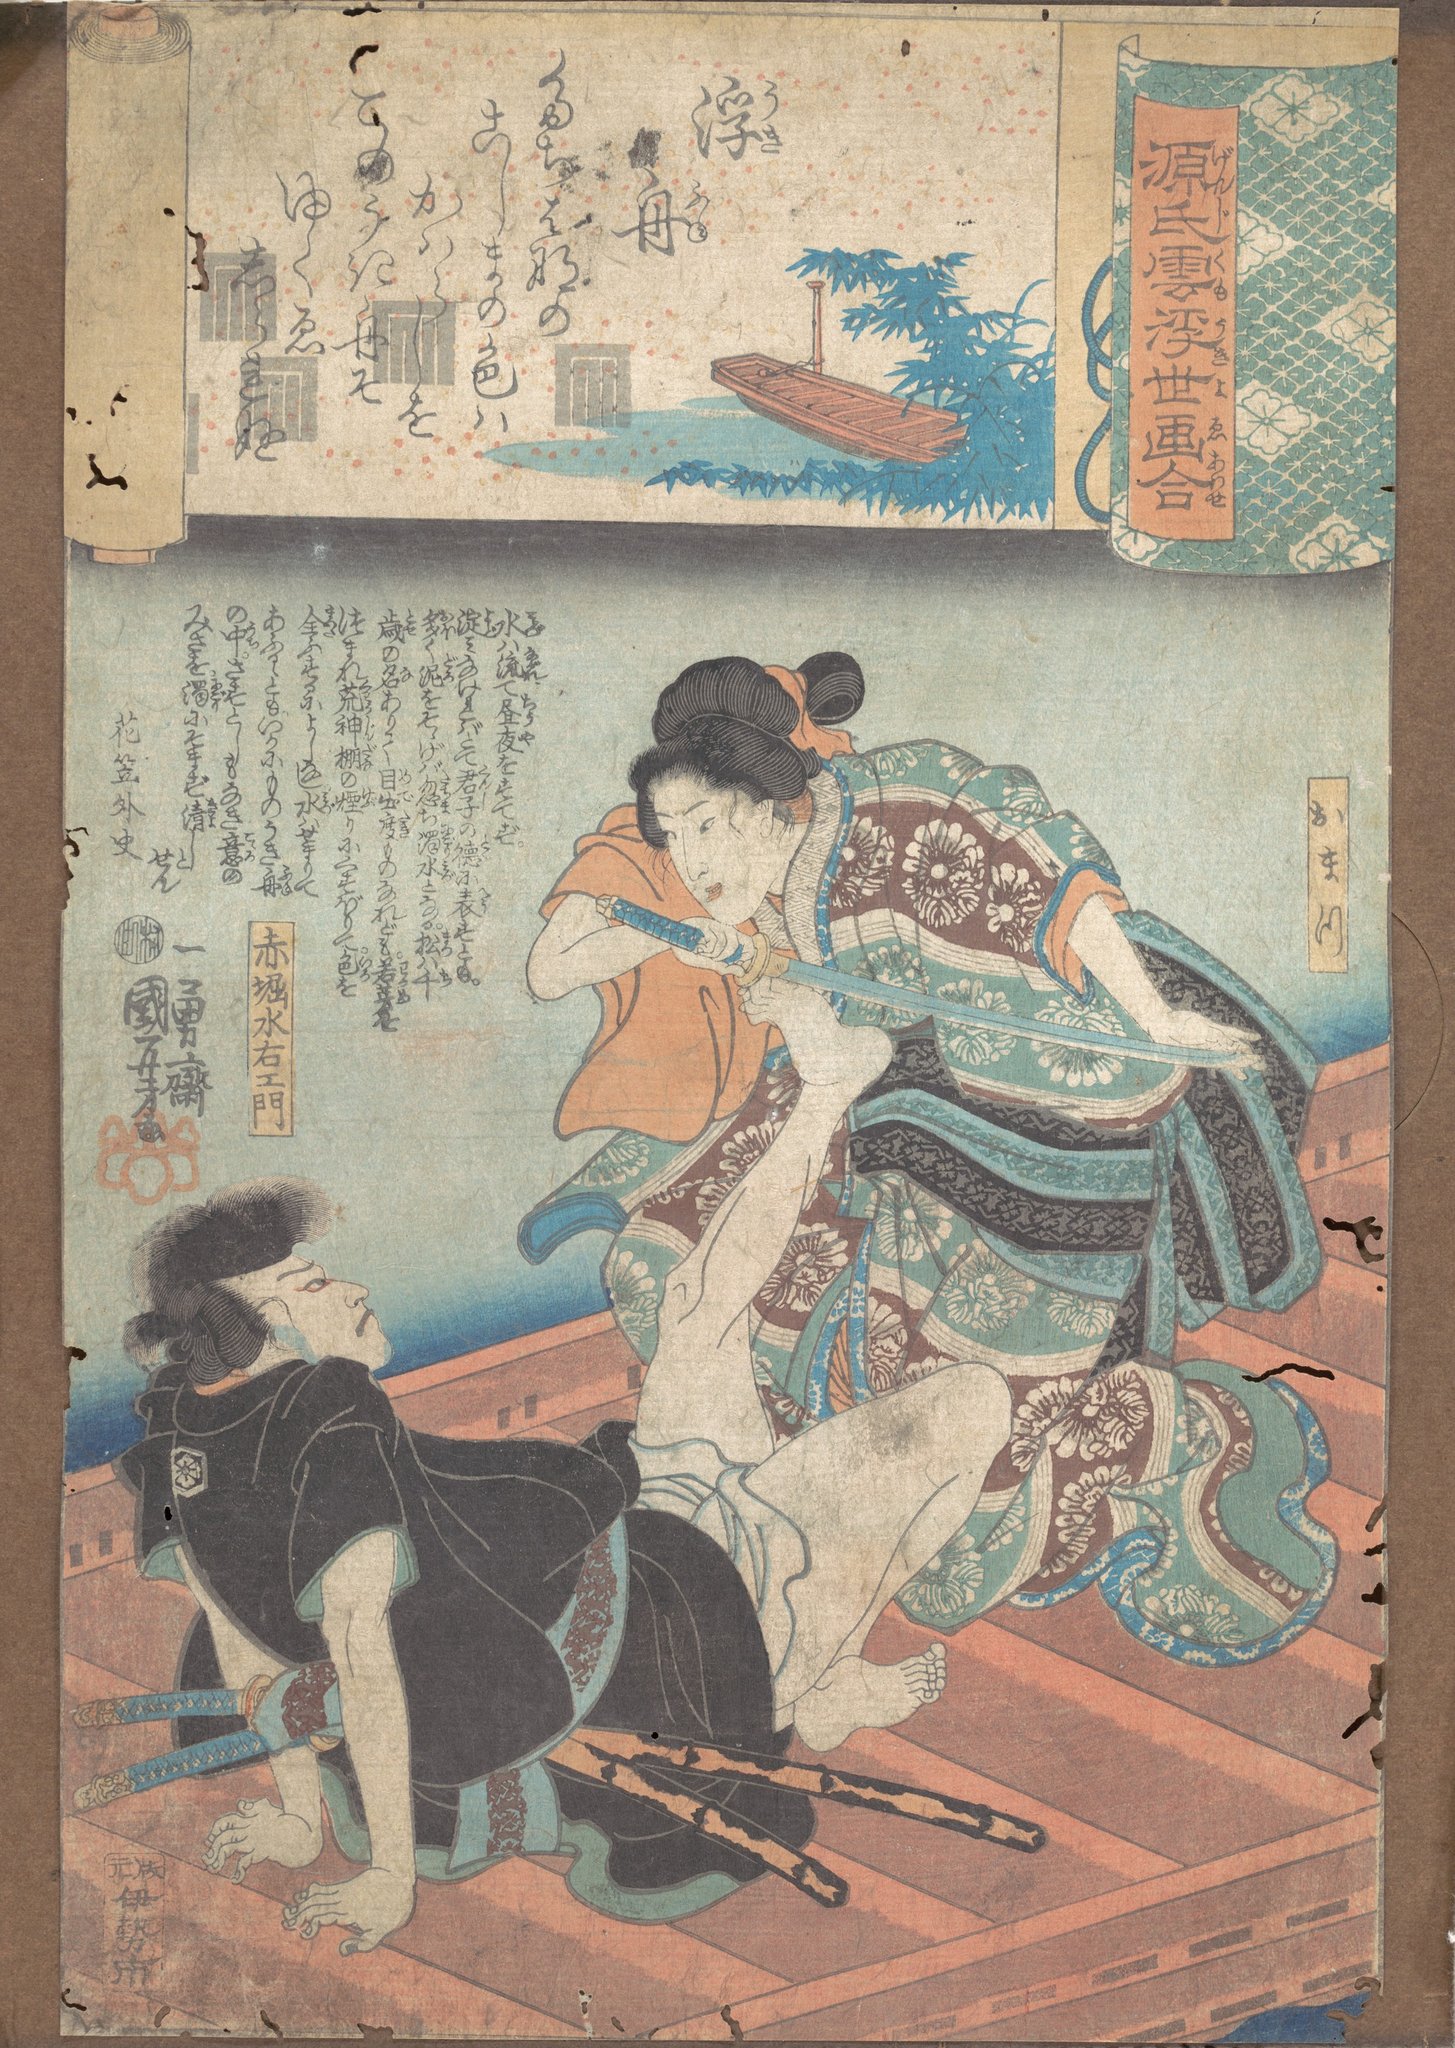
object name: print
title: A Boat upon the Waters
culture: japanese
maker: utagawa kuniyoshi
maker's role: artist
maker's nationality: japanese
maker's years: 1797-1861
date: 1845-1846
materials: ink, paper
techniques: woodblock print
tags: swords,men,boats